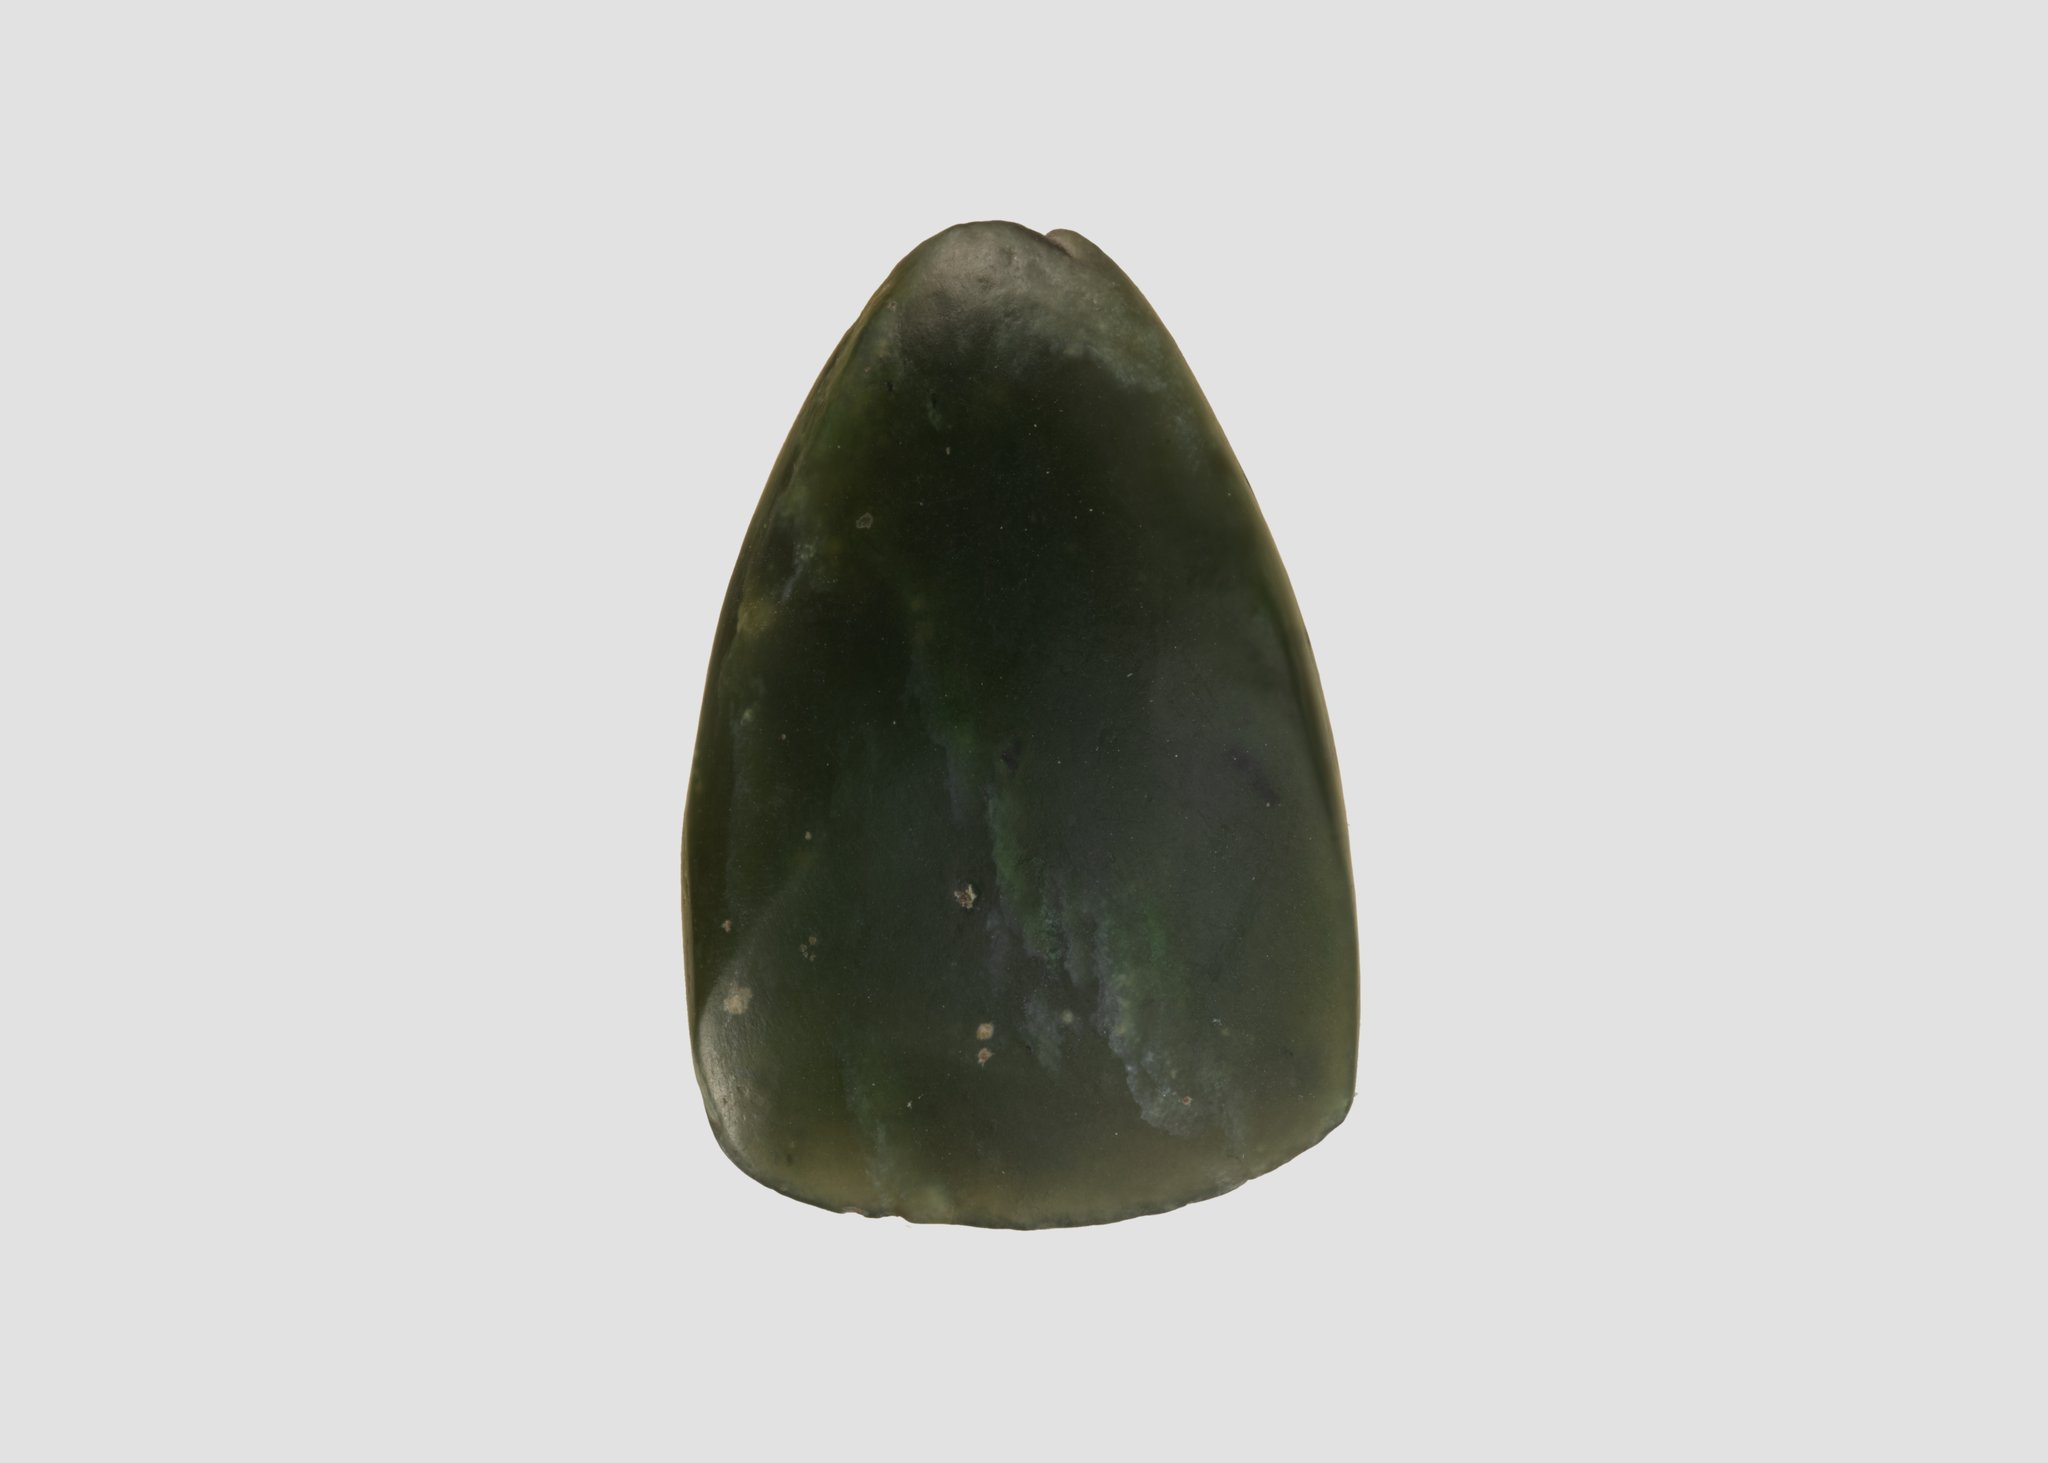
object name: celt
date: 7000-5001 BCE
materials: stone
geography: syria